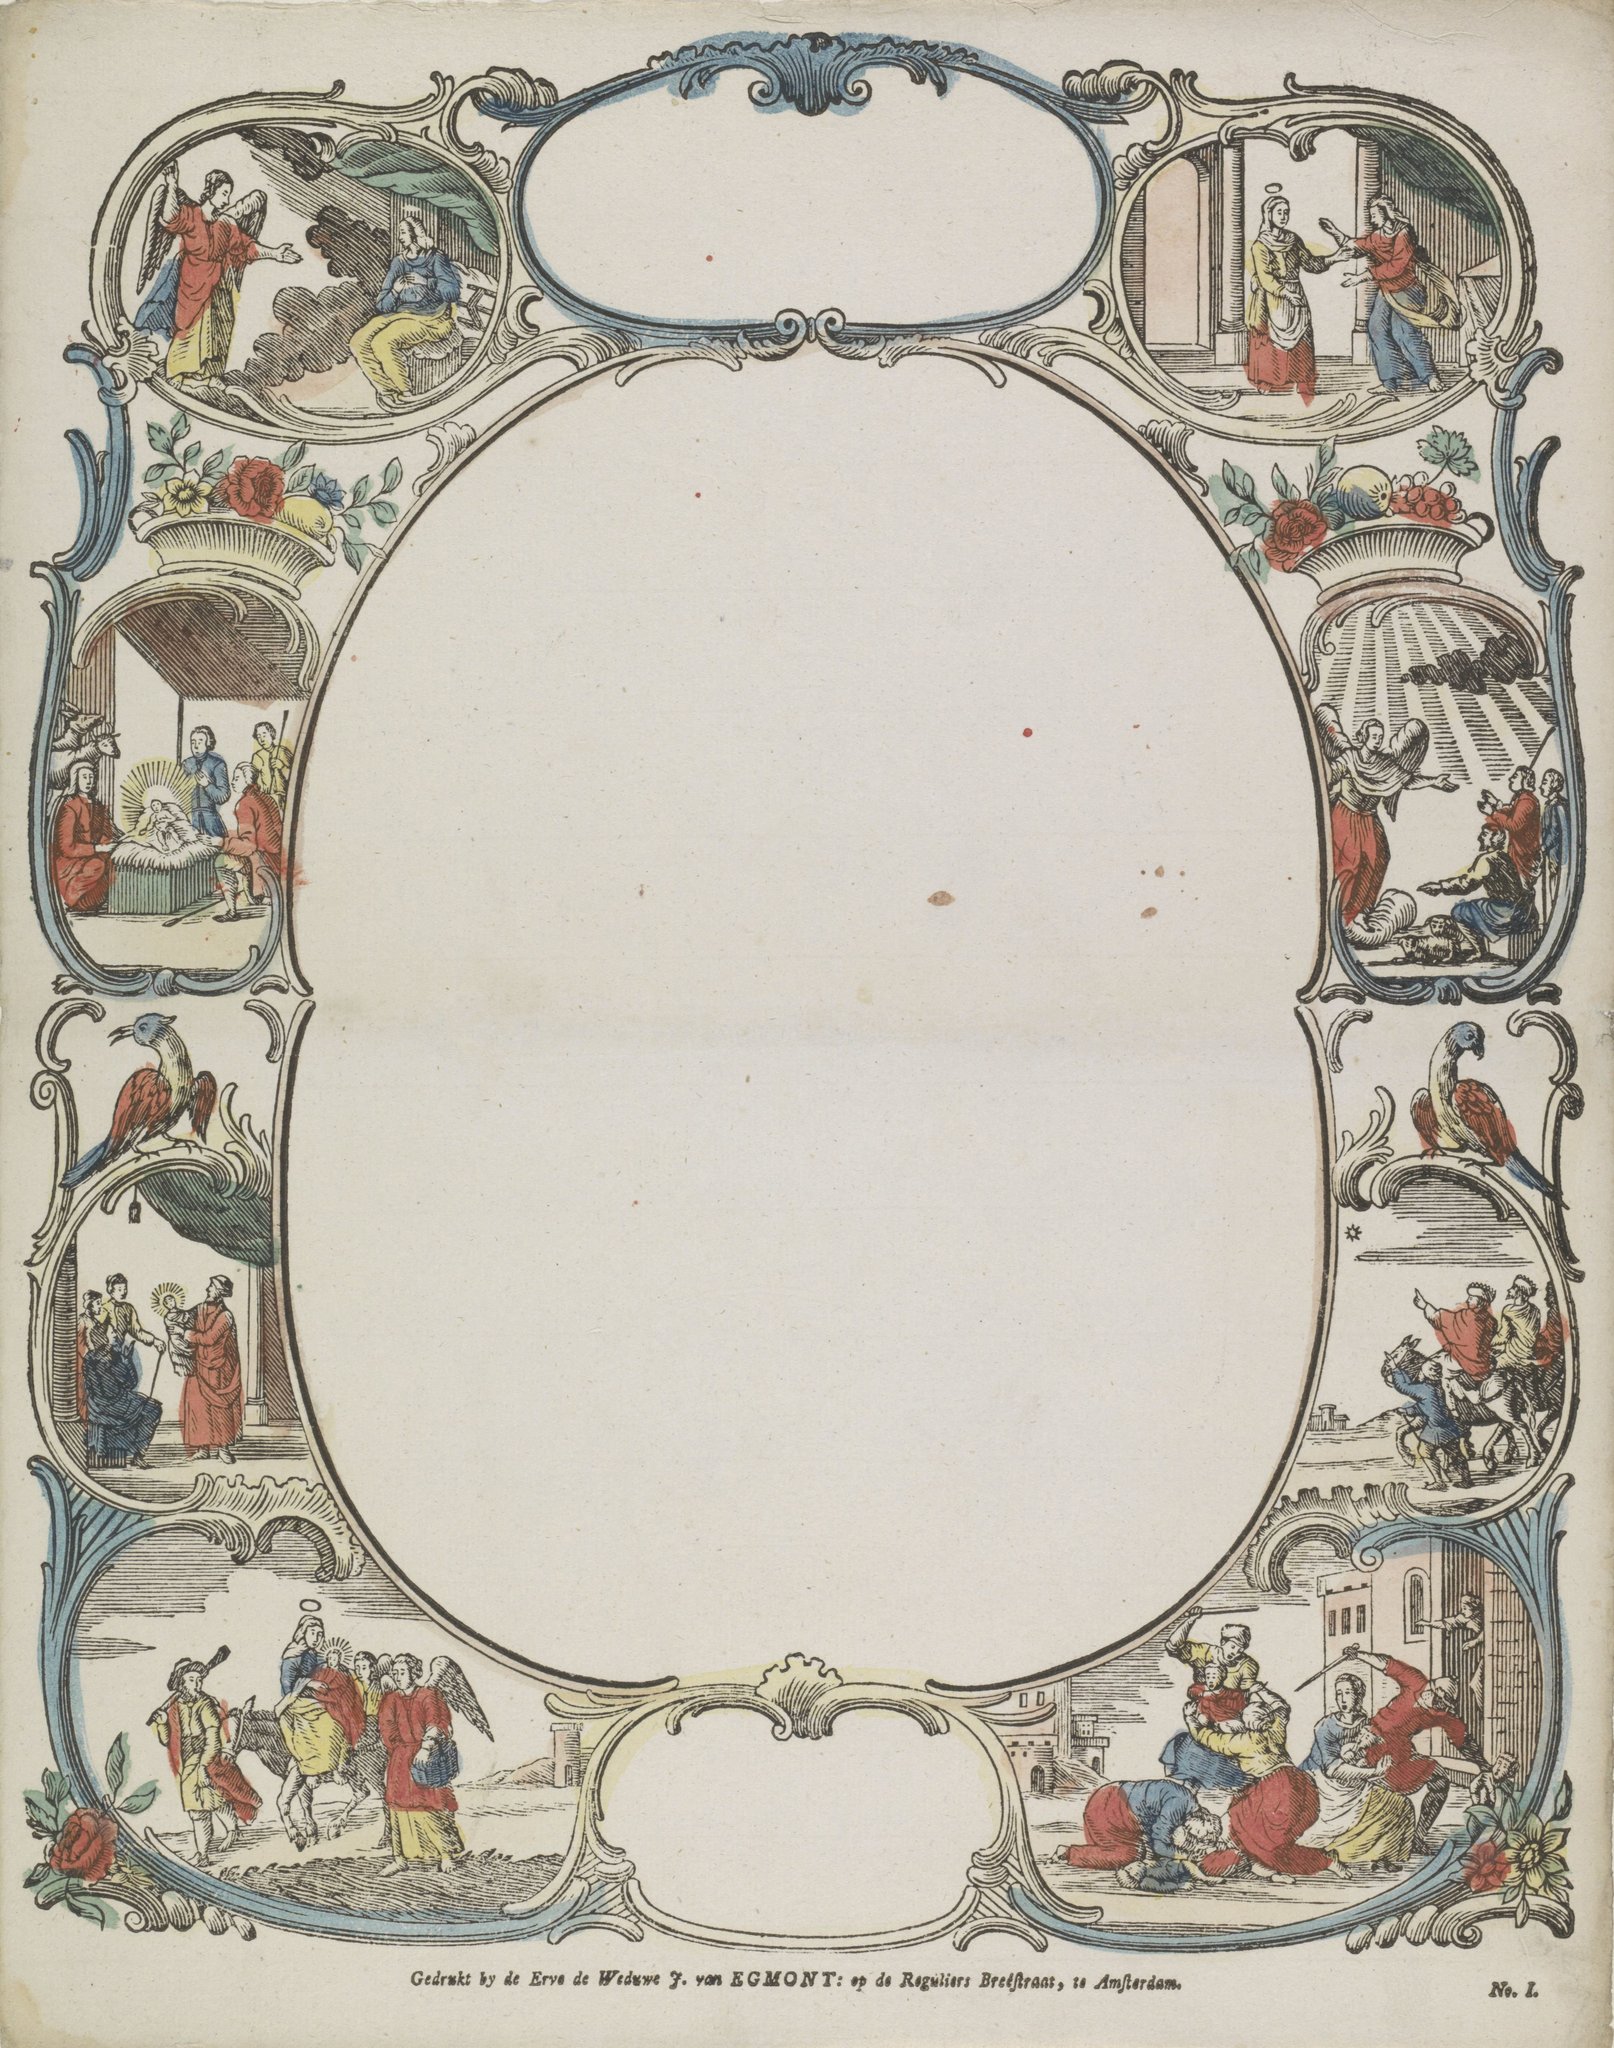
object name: print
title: Wensbrief met voorstellingen uit het Nieuwe Testament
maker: Anonymous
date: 1761-1804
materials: paper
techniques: colour, letterpress printing, engraving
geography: netherlands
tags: new testament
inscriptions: collector's mark: Lugt 2760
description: Wensbrief met onbeschreven cartouche binnen een decoratief kader met voorstellingen uit het Nieuwe Testament. Genummerd rechtsonder: No. 1.